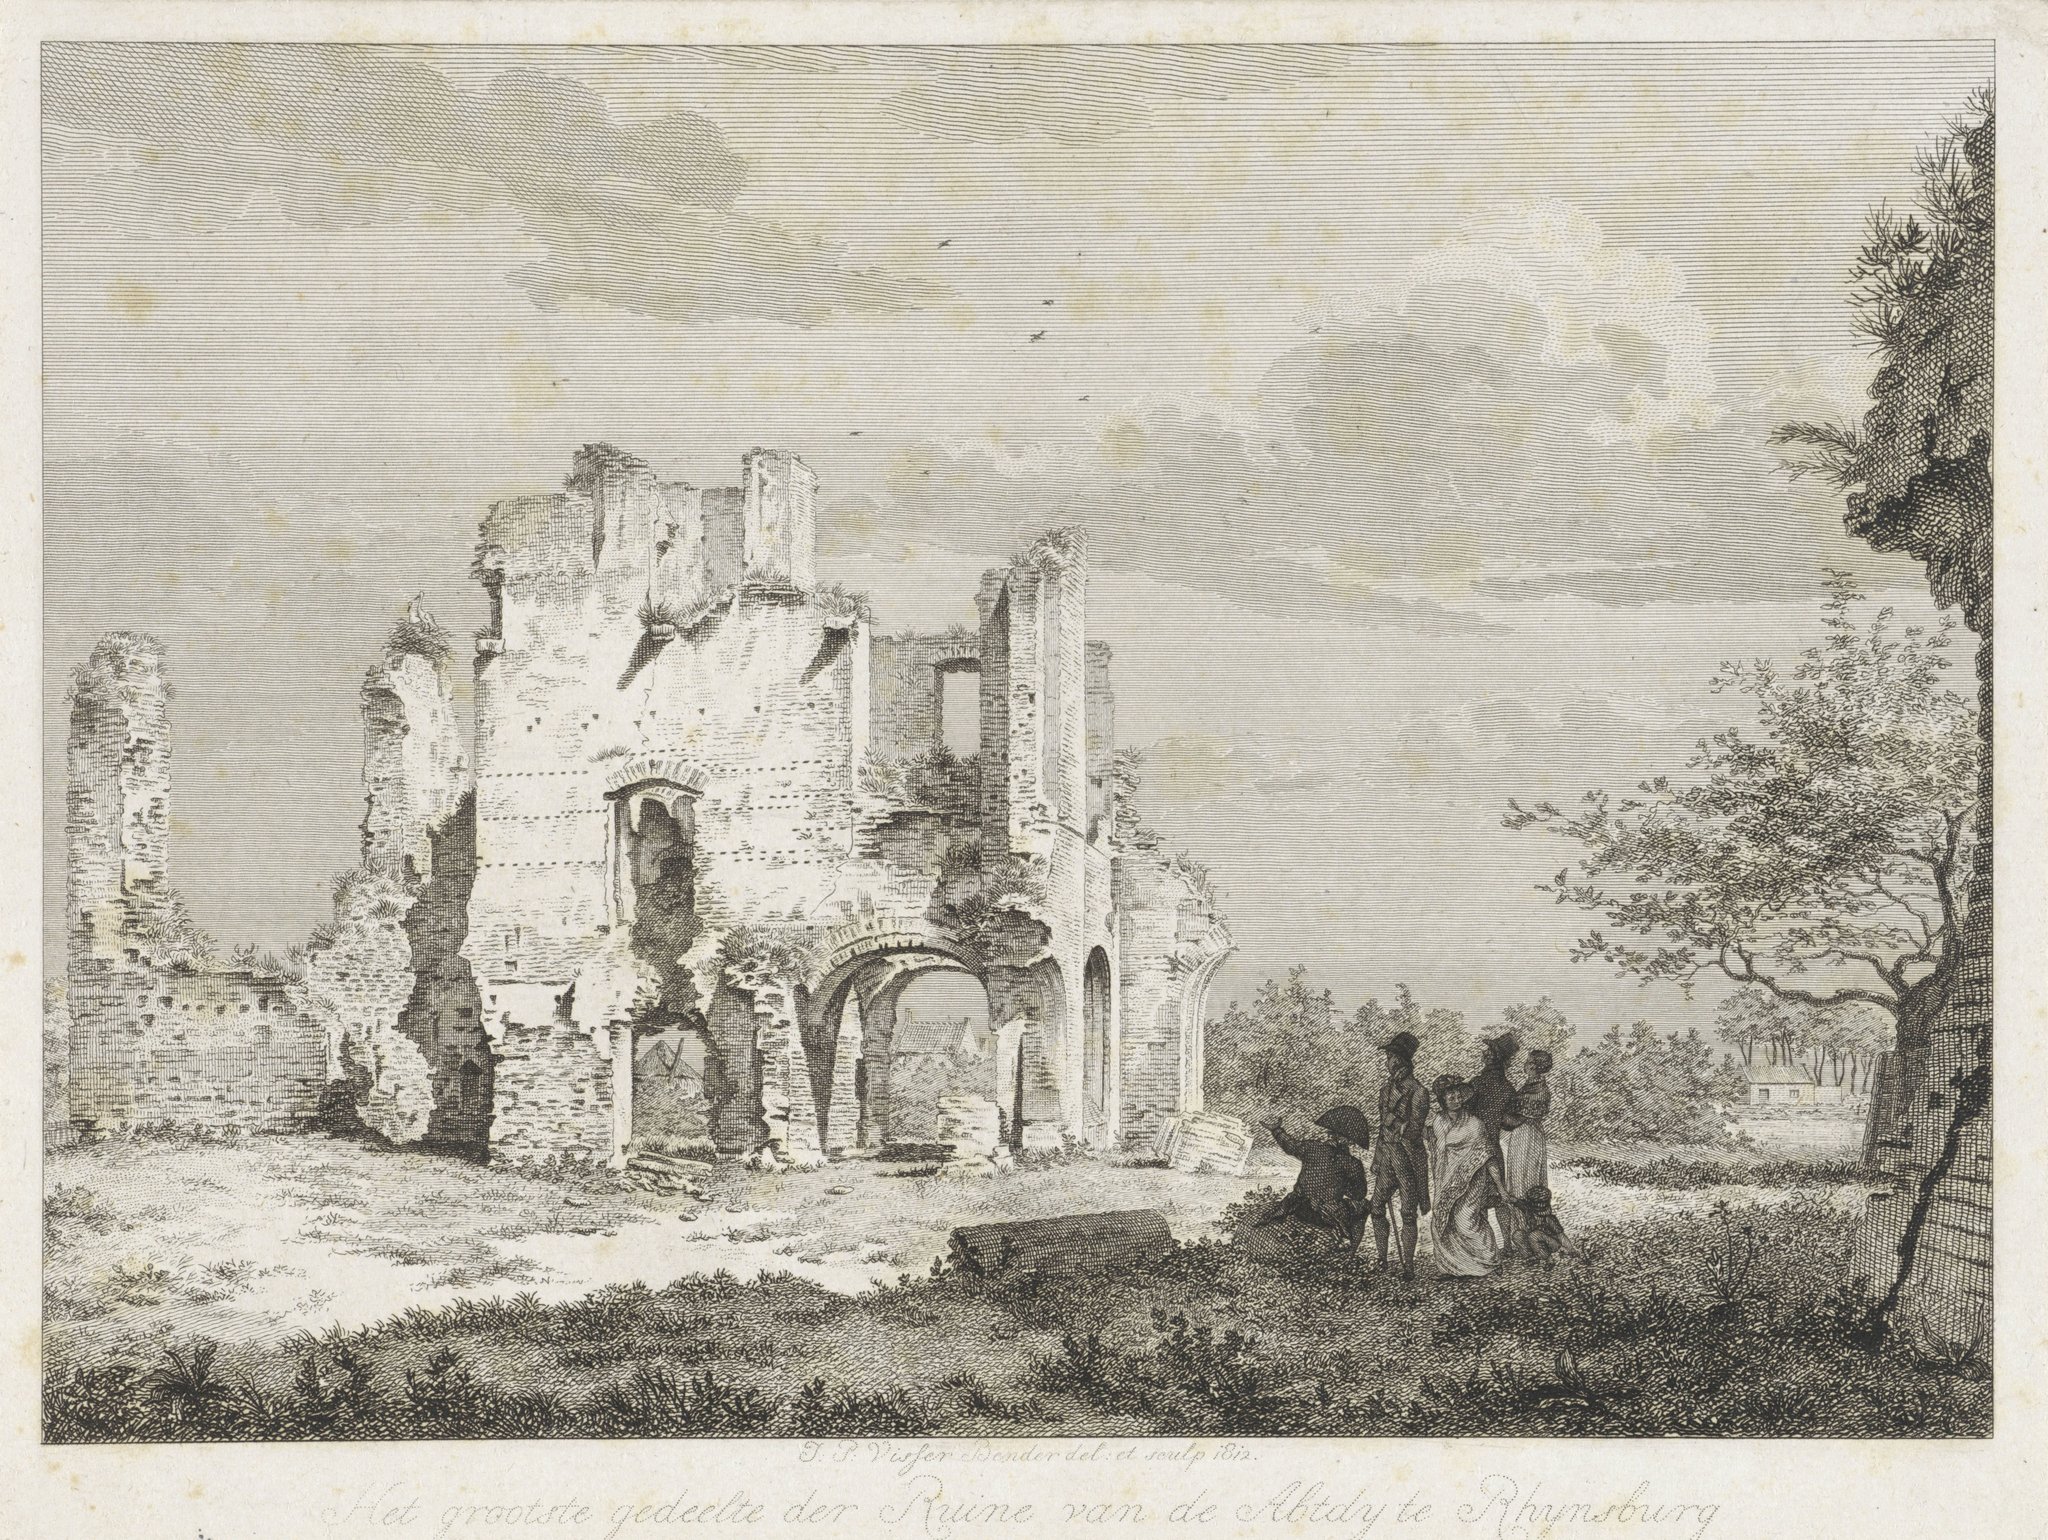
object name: print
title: Gezelschap bij de ruïne van de abdij te Rijnsburg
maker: joannes pieter visser bender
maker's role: draughtsman, print maker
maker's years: 1785-1813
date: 1812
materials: paper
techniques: etching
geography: haarlem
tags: ruin of church, monastery, etc.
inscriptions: collector's mark: Lugt 2228, collector's mark: Lugt 2760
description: Gezicht op de ruïne van de abdij te Rijnsburg. Op de voorgrond een gezelschap.